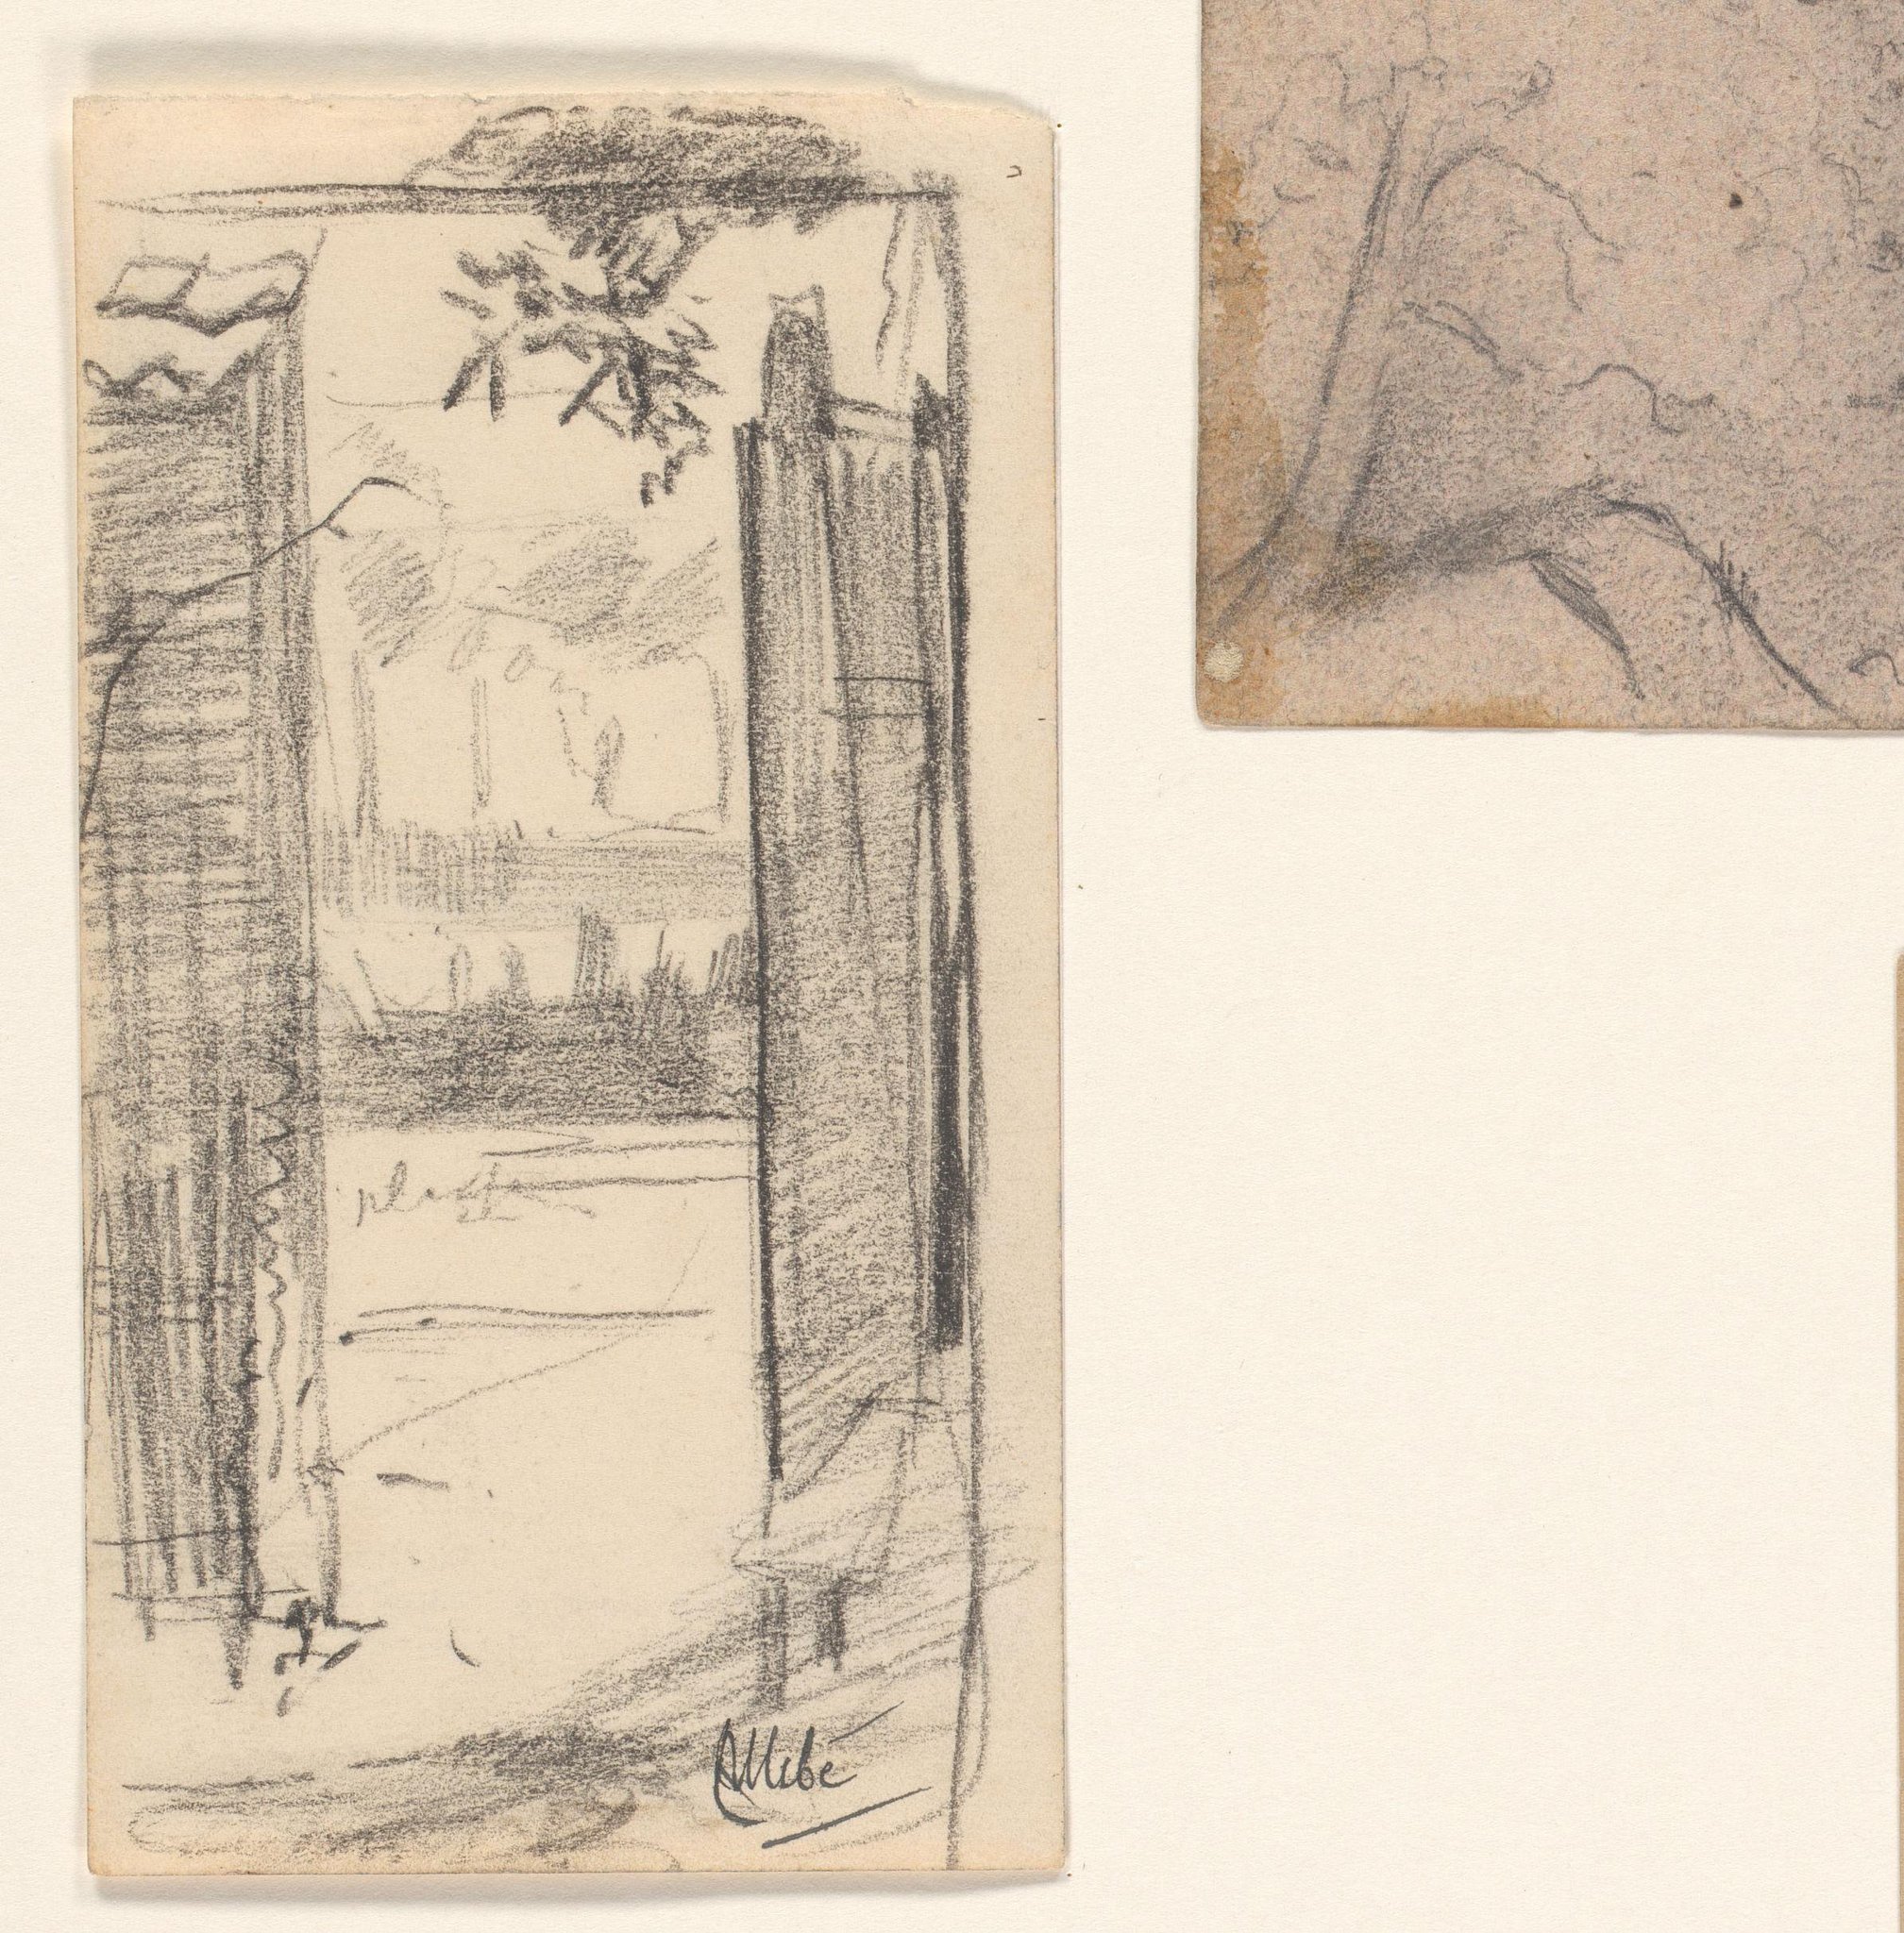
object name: drawing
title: Deuropening waardoor men een landschap ziet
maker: august allebé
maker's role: draughtsman, print maker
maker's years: 1838-1927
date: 1848-1927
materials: chalk, paper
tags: door